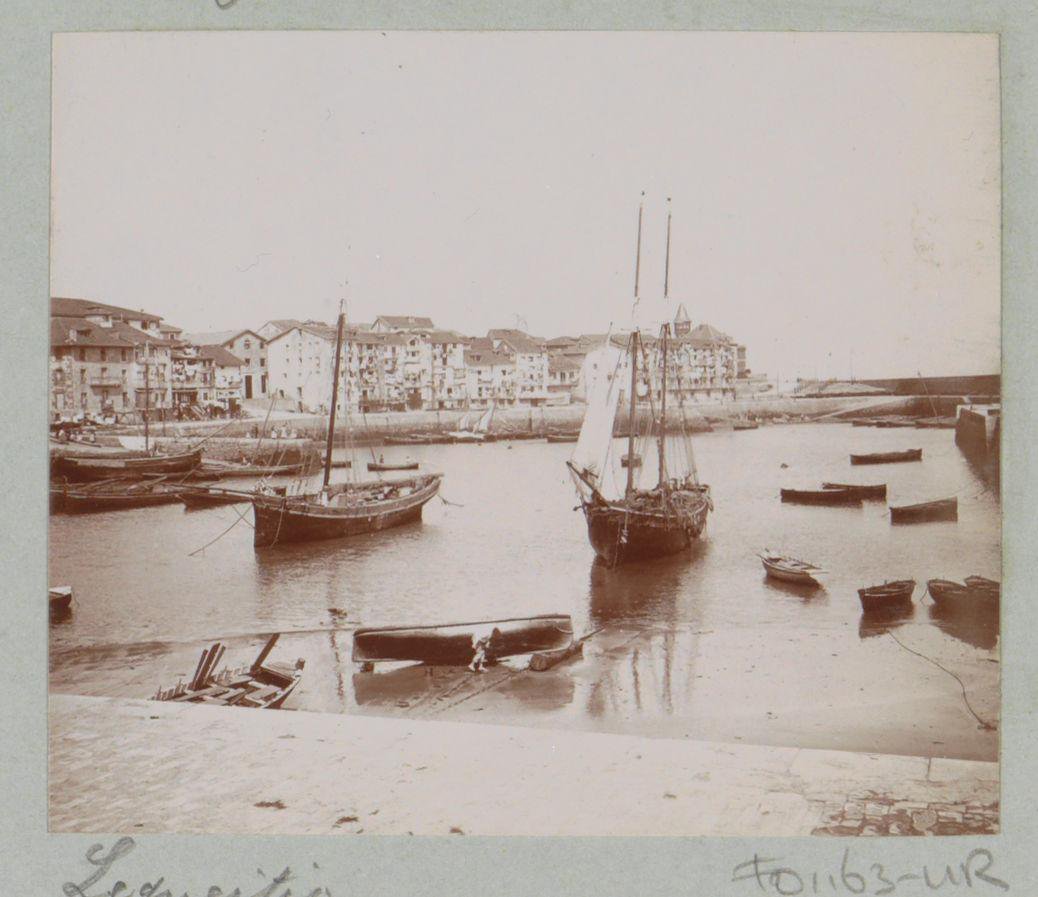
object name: photograph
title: Gezicht op de haven van Lekeitio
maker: delizy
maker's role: manufacturer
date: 1904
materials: paper, photographic support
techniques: gelatin silver print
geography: lekeitio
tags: sailing-ship, sailing-boat, harbour (+ view ~ vehicle, ship, etc.), prospect of city, town panorama, silhouette of city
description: Onderdeel van Fotoalbum van een Franse amateurfotograaf met opnames van uitstapjes in Frankrijk, Spanje, België, Luxemburg en Nederland, de eerste automobielen en autoraces.